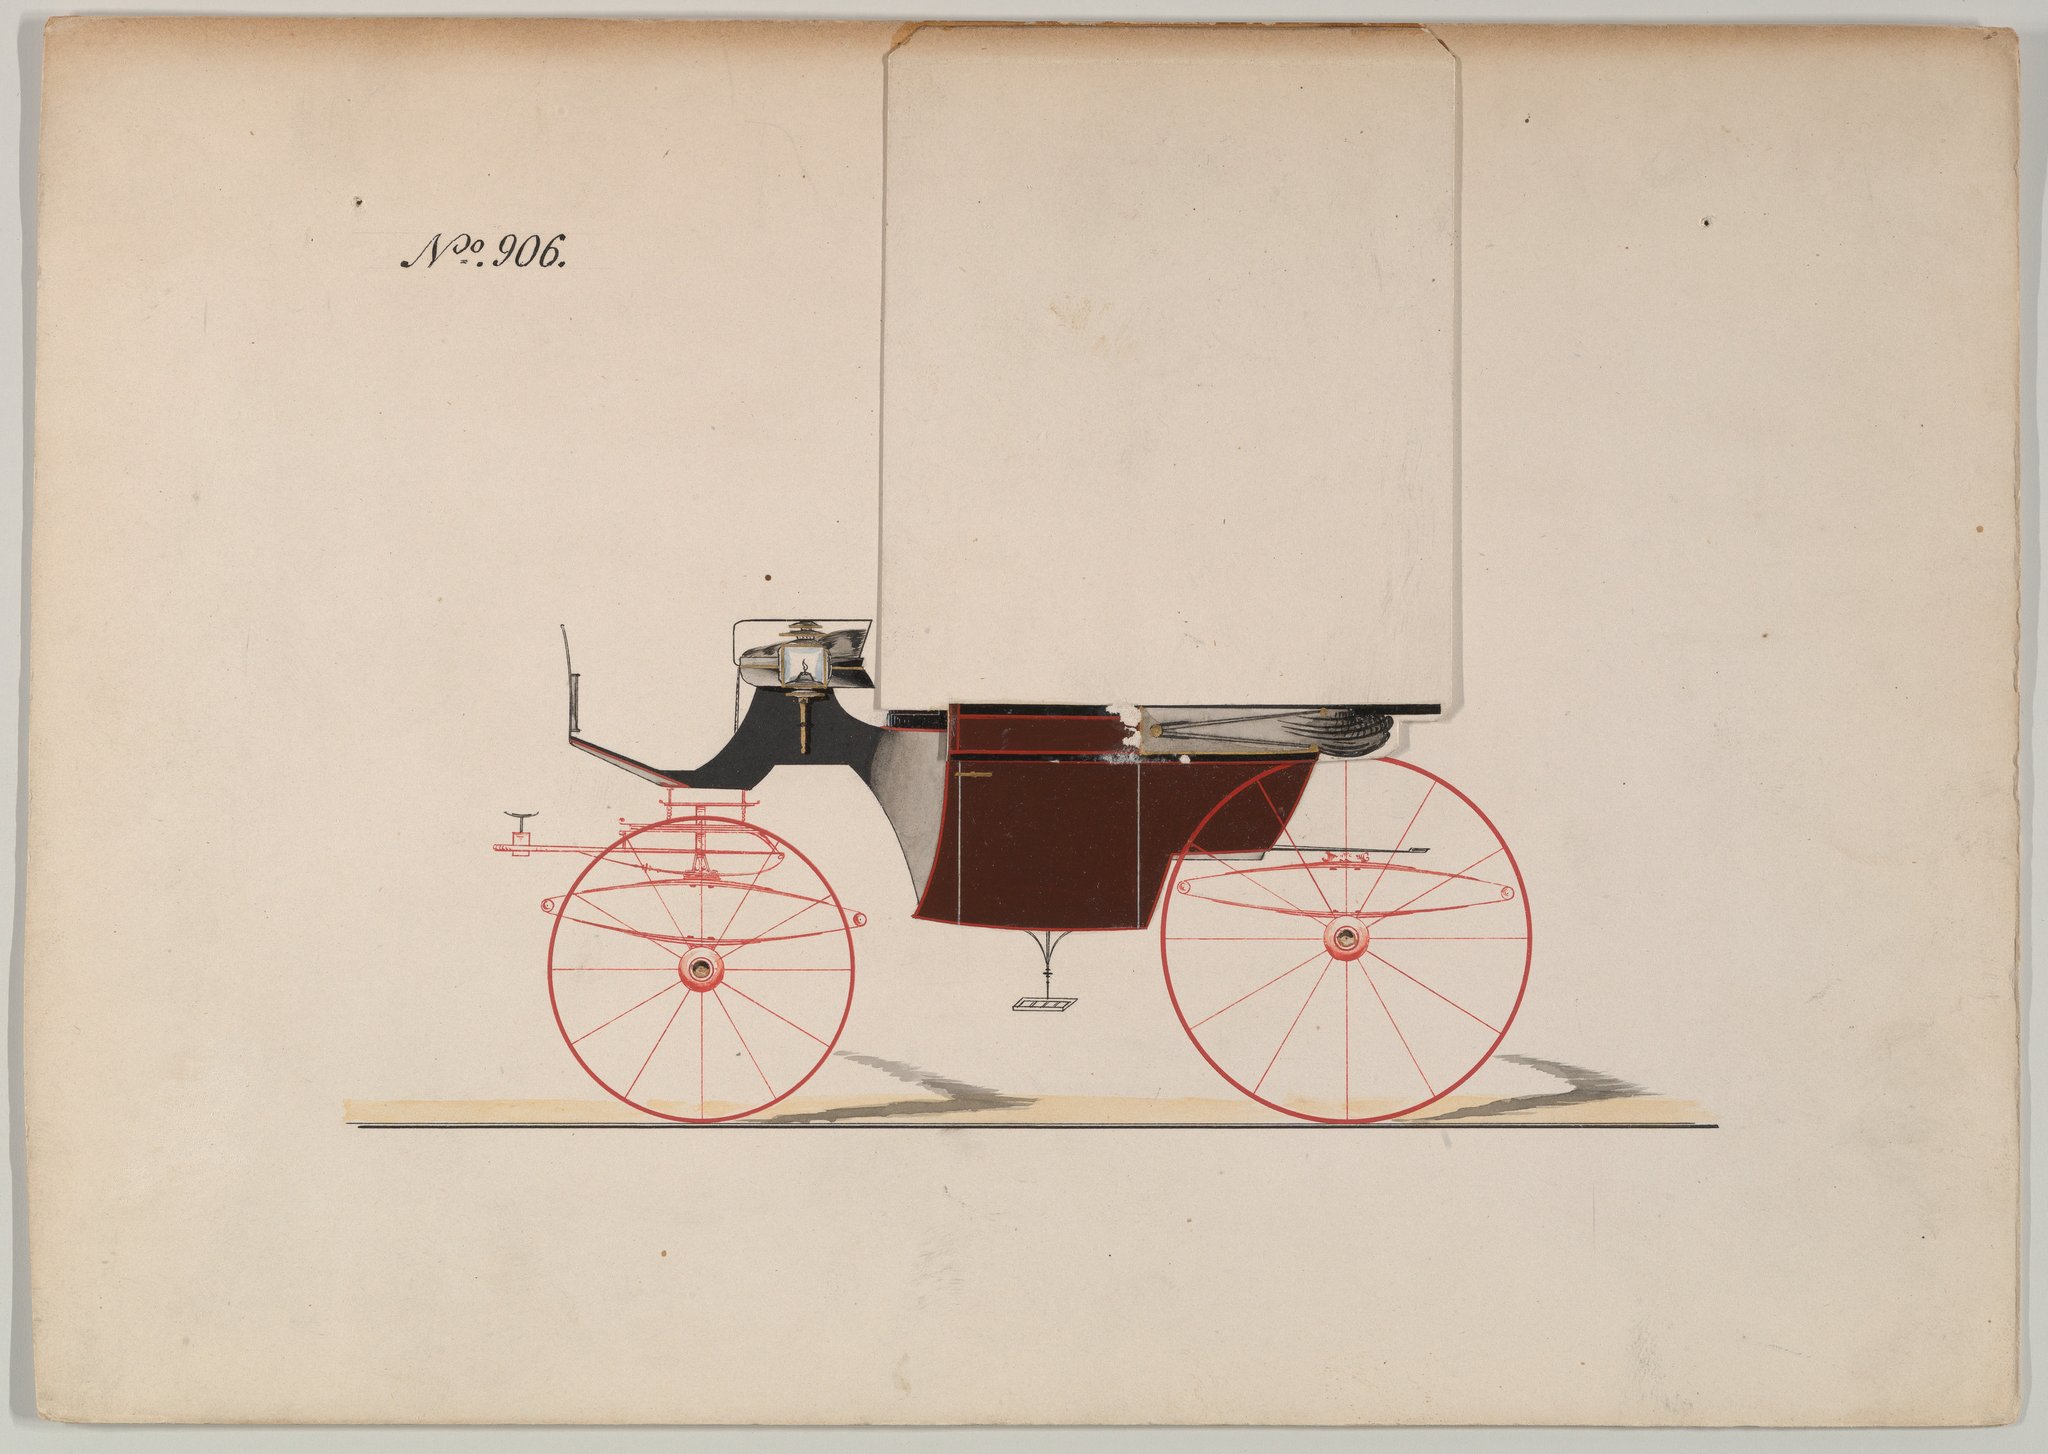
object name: drawing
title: Landaulet #906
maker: brewster & co.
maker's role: manufacturer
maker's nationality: american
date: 1850-1870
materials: gouache, gum arabic, ink, watercolor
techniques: pen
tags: carriages